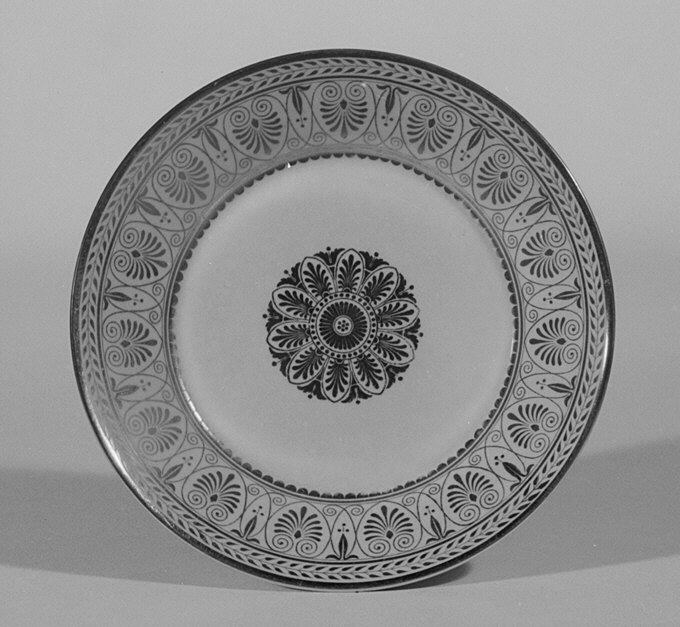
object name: saucer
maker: sèvres manufactory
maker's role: manufactory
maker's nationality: french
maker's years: 1740-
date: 1832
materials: hard paste porcelain